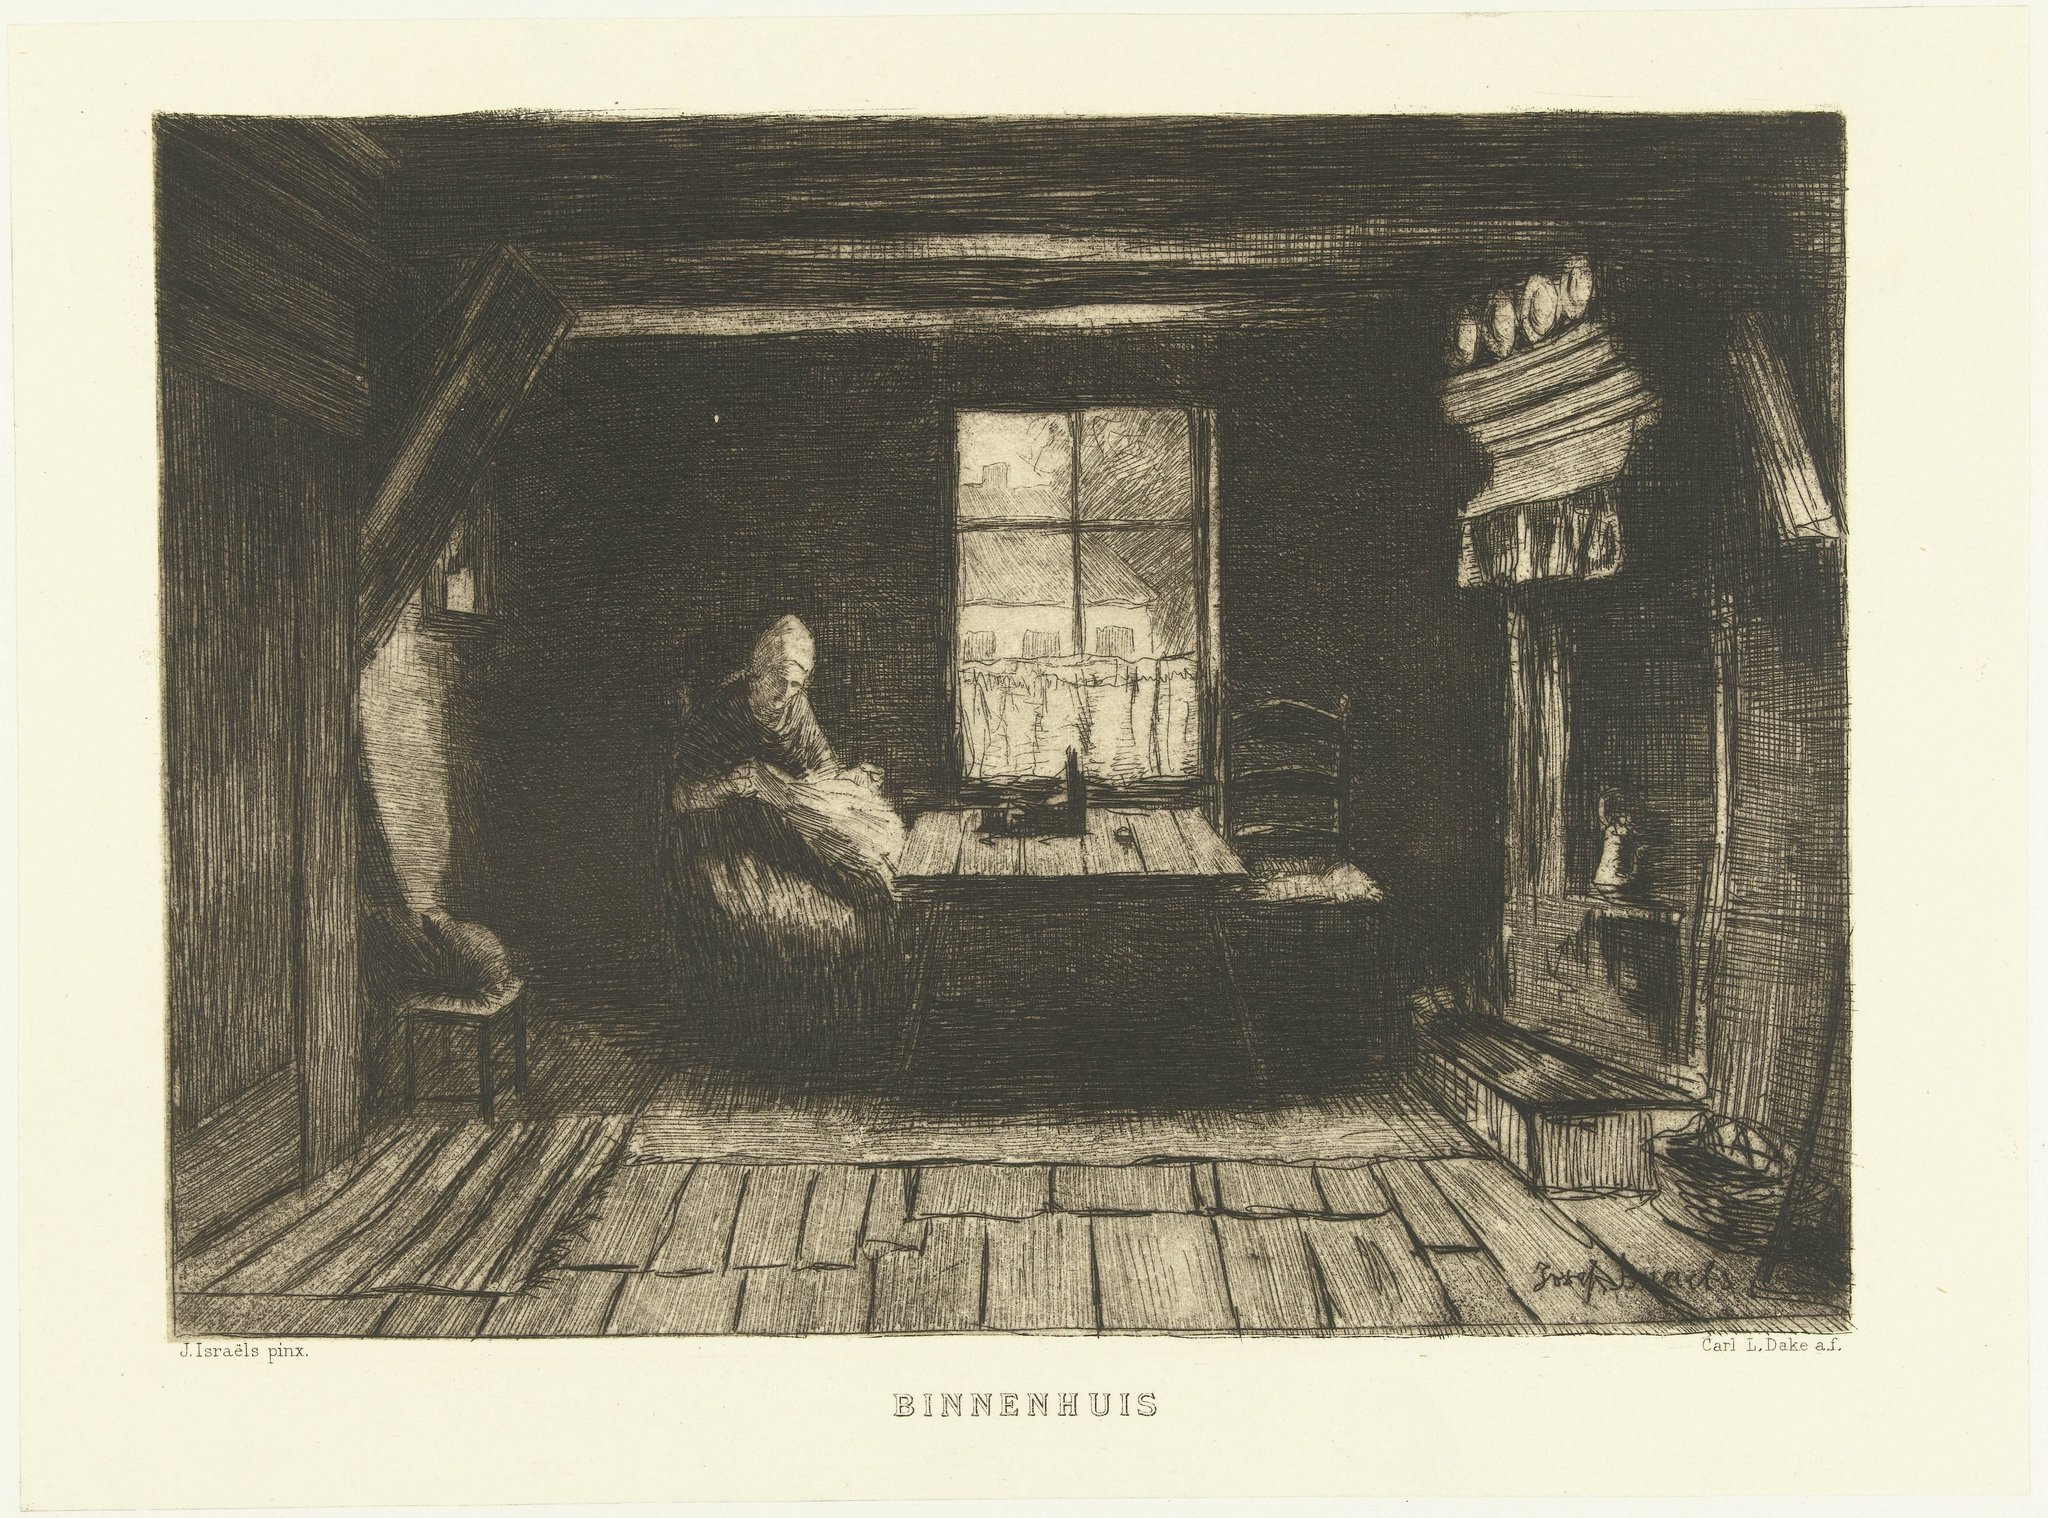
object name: print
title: Interior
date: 1867-1909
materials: paper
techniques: drypoint, etching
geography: netherlands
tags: living-room, parlour, sitting-room, sewing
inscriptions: collector's mark: Lugt 2228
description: Coll. de la Faille. Prent naar schilderij van Jozef Israëls.